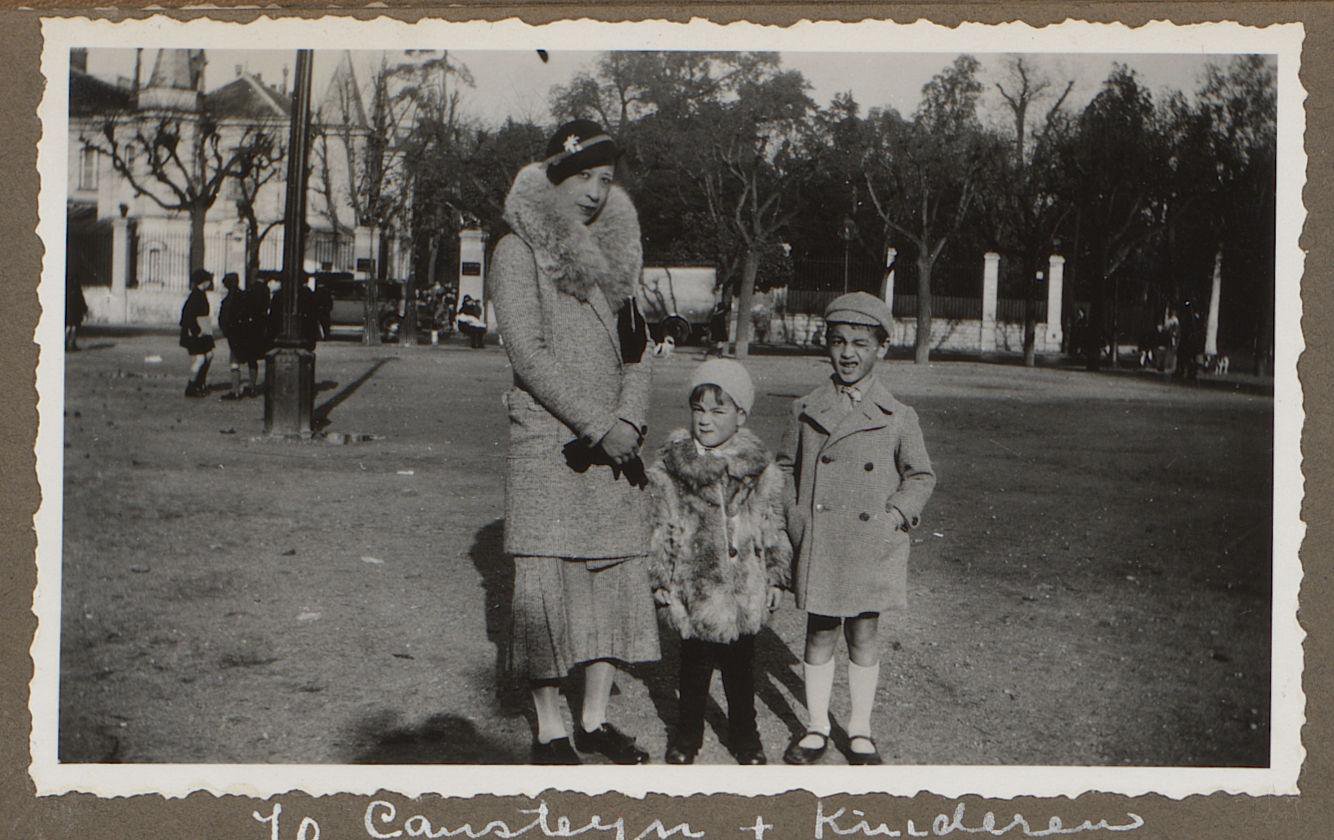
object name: photograph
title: Jo van Raab van Cantstein met twee kinderen, Parijs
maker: Anonymous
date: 1911-1933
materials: paper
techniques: gelatin silver print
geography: paris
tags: historical persons - bb - woman, historical persons not known by name, paris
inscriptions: inscription: ‘Jo Cansteyn + kinderen’